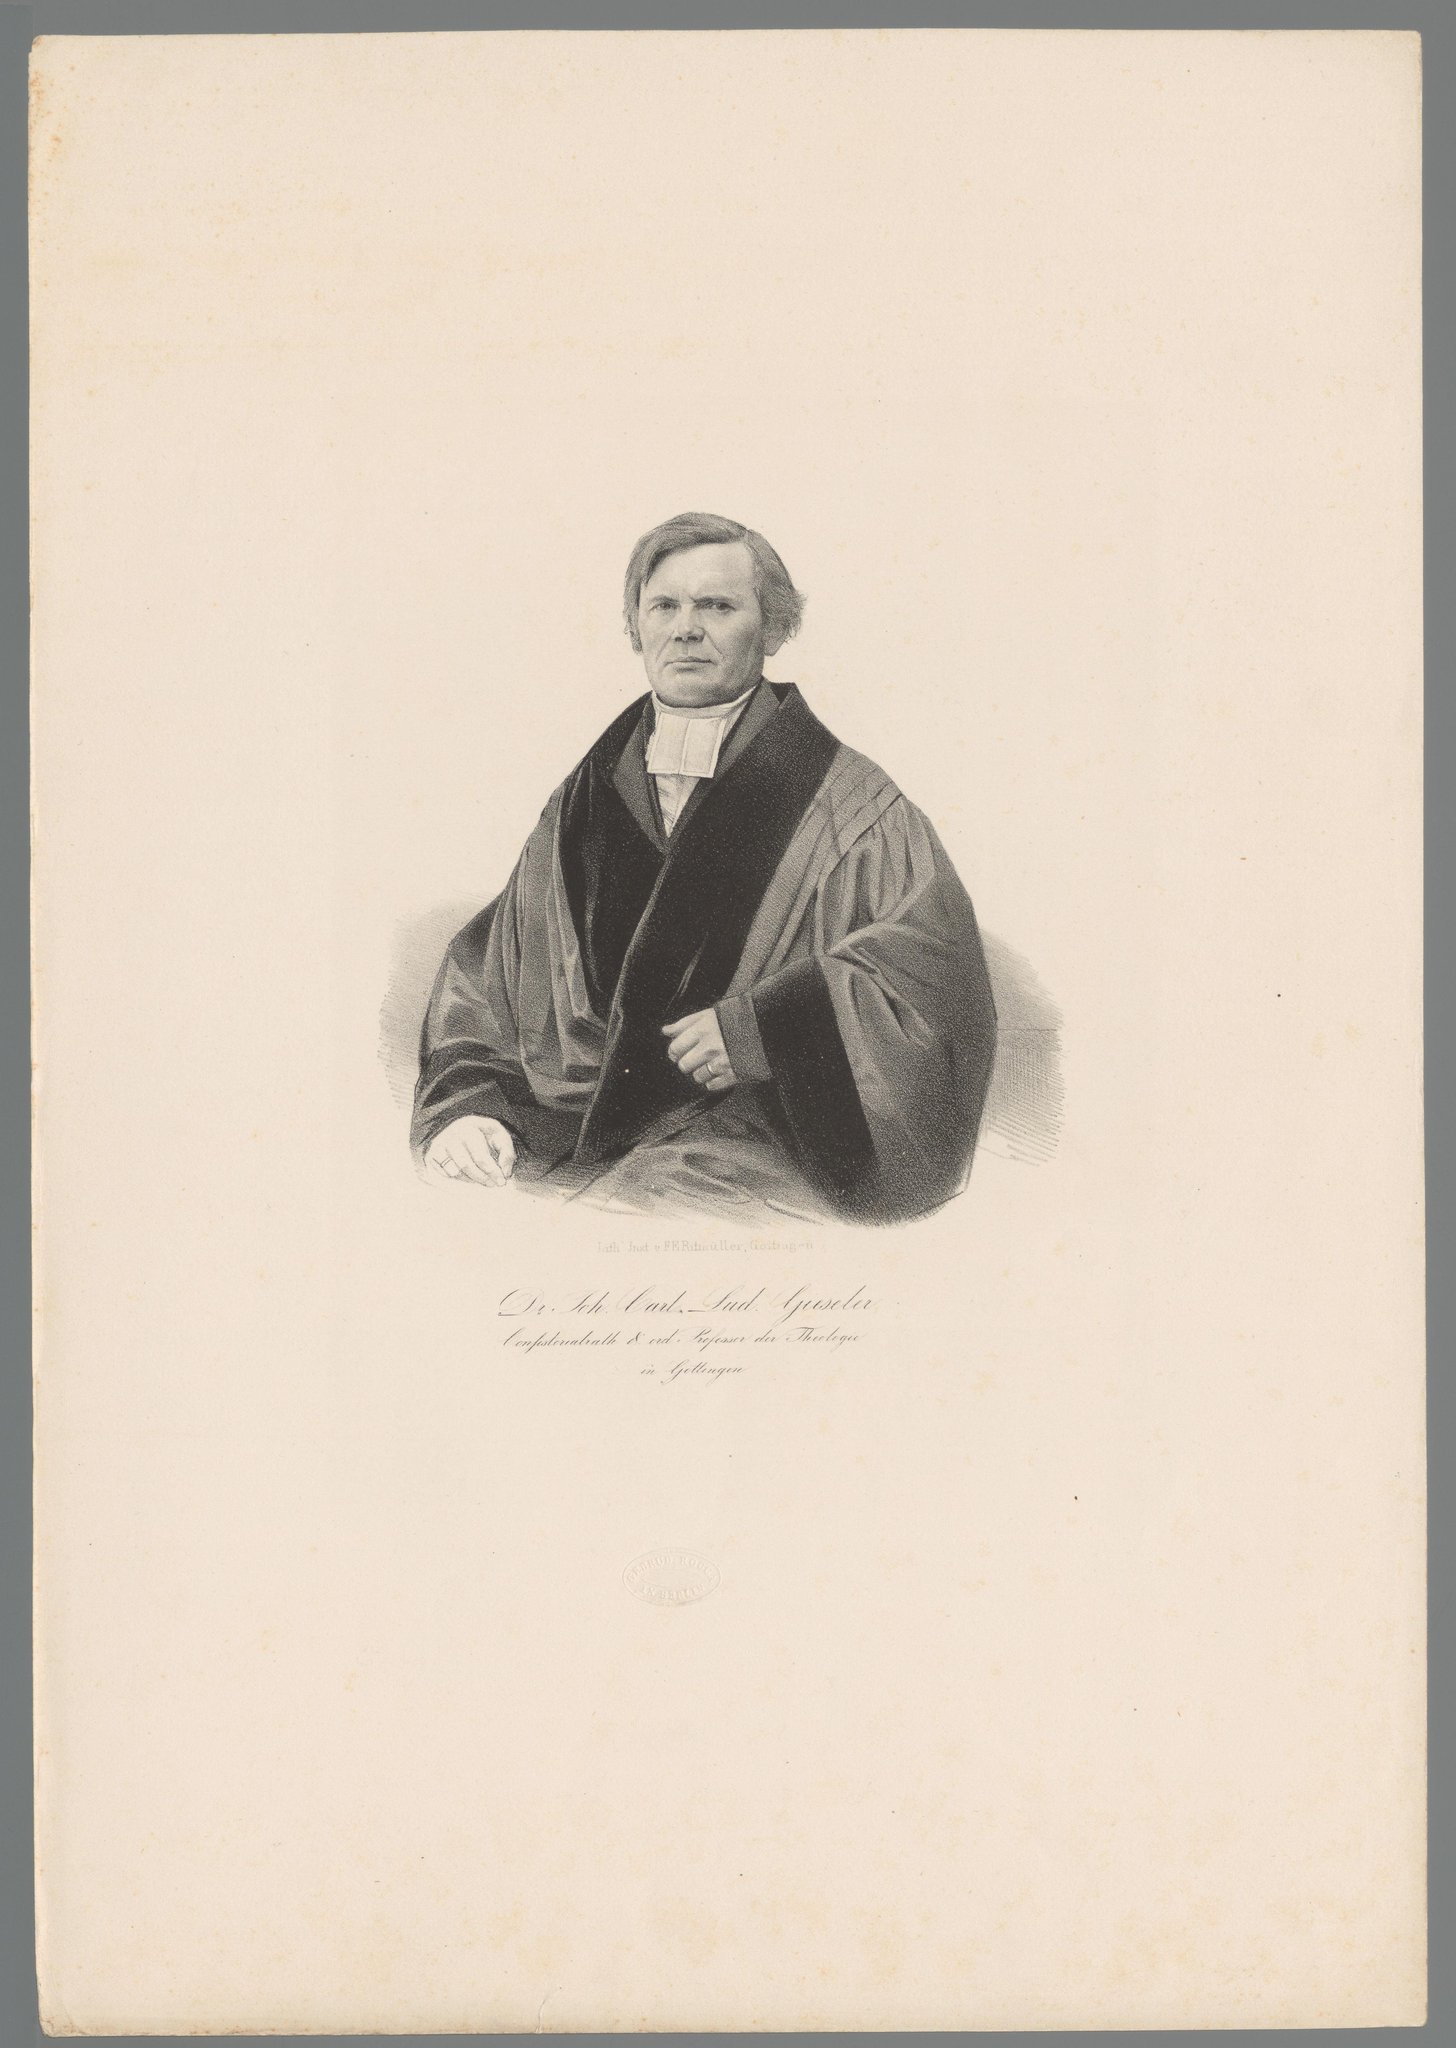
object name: print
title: Portret van Johann Karl Ludwig Gieseler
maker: friedrich eduard ritmüller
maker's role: printer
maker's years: 1805-1869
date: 1830-1863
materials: paper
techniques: lithograph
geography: gottingen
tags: history and archaeology (+ portrait of scholar, scientist), historical persons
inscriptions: check stamp: Lugt 2141c, collector's mark: Lugt 2228